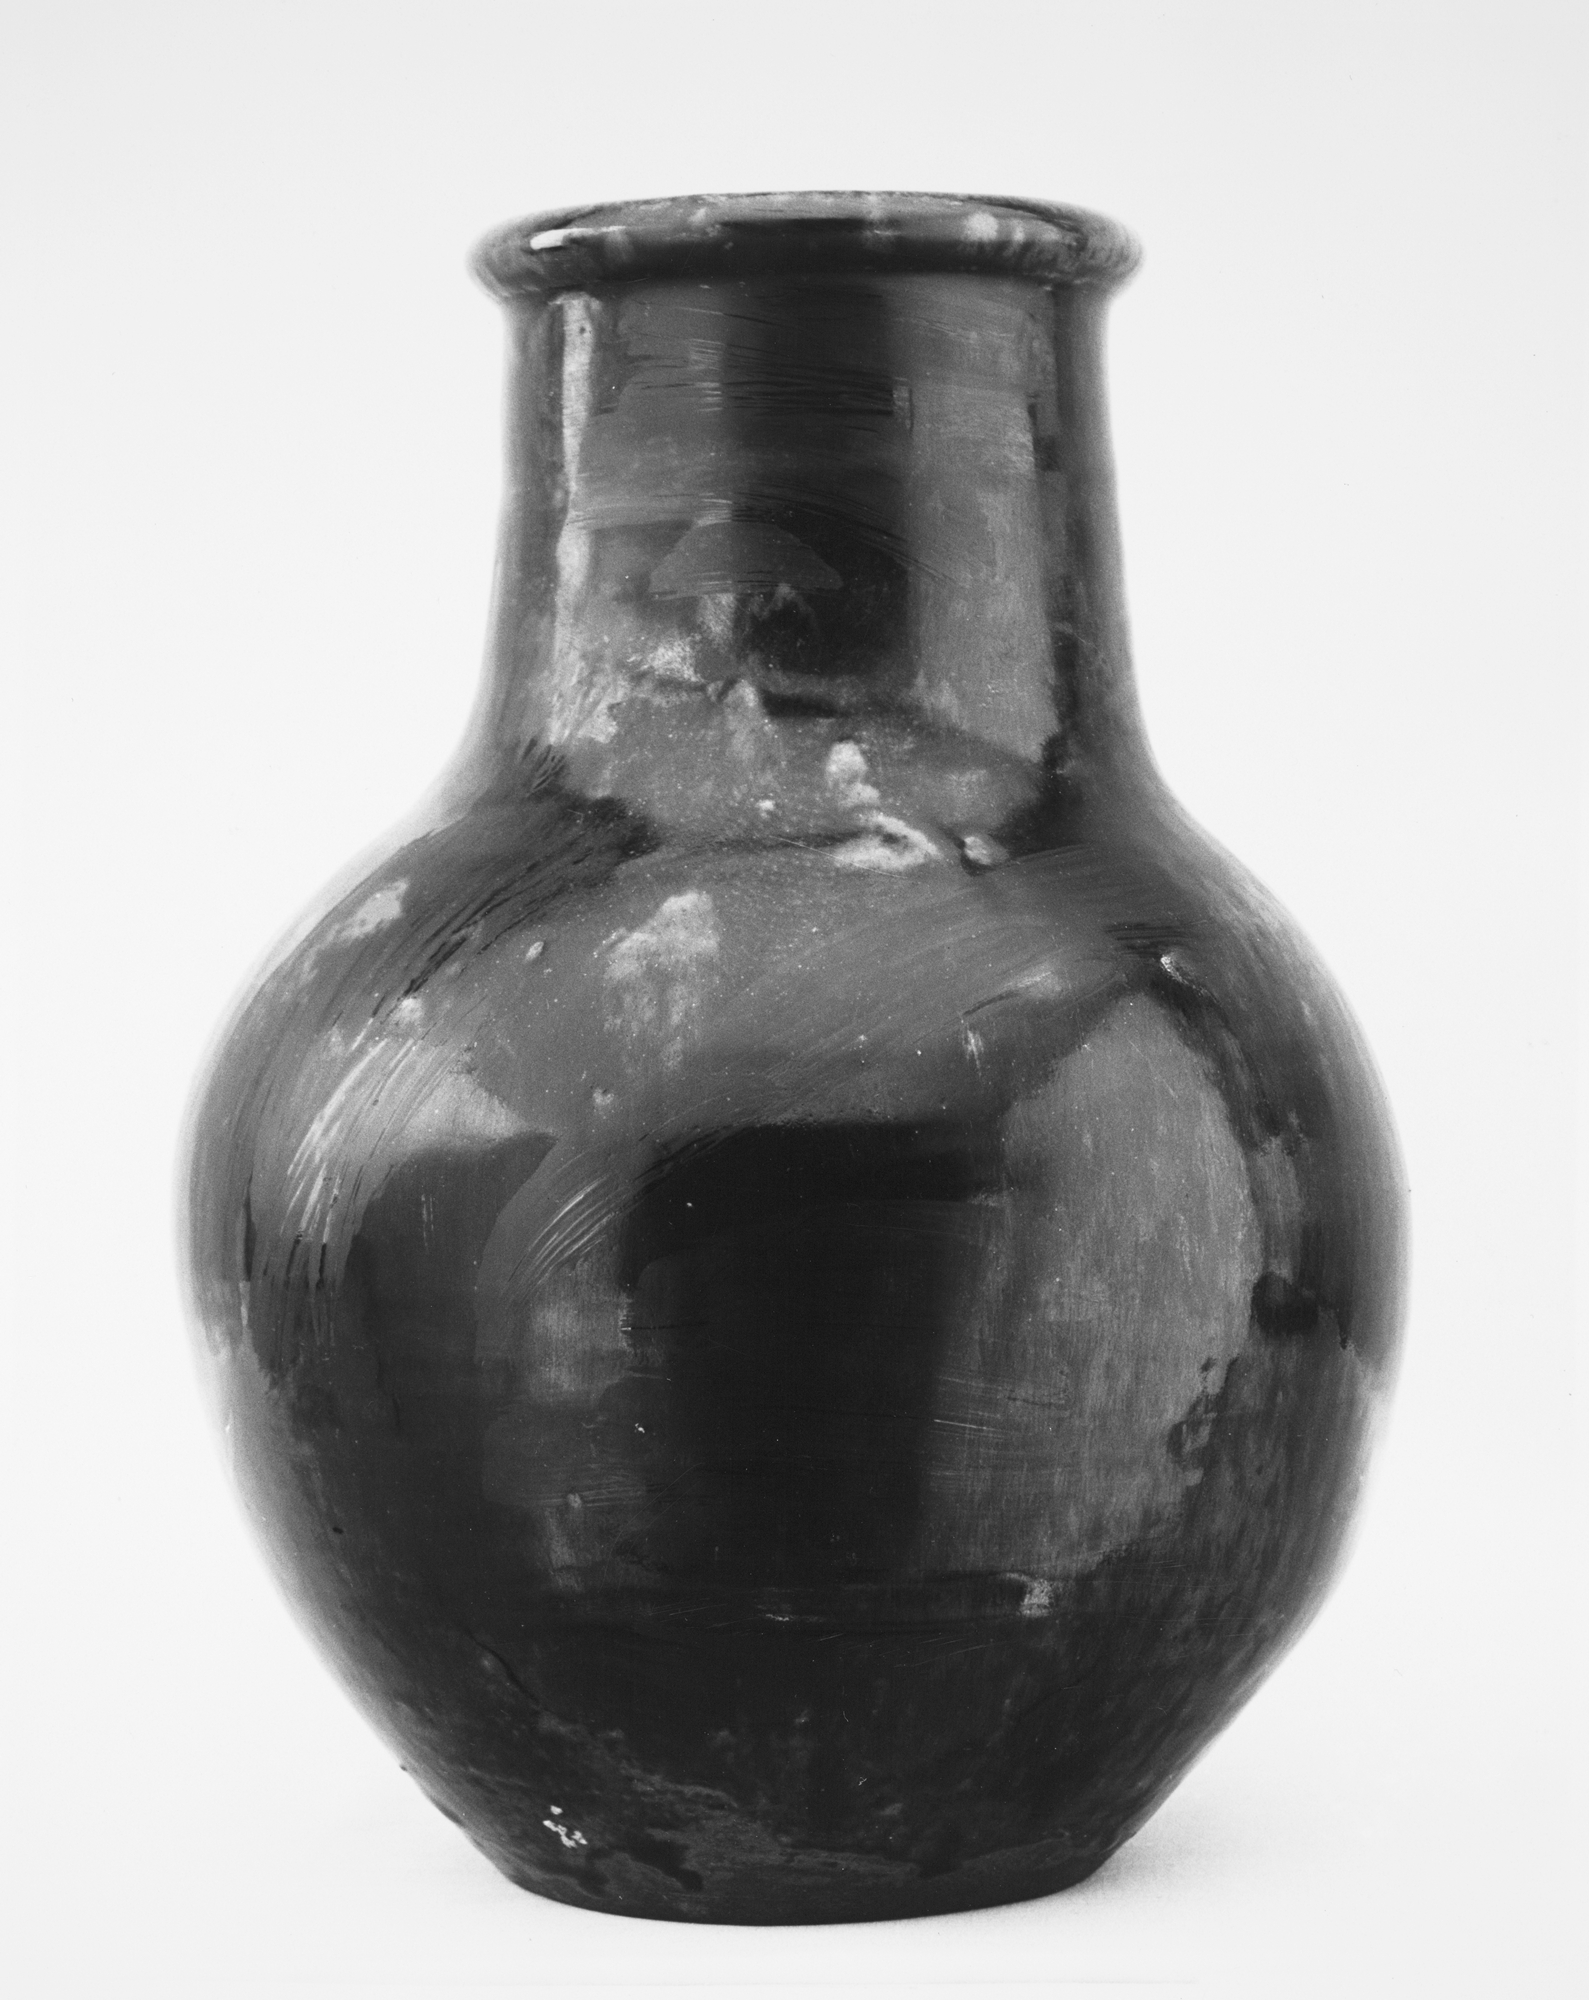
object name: jar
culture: japanese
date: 1701-1800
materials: clay, glaze